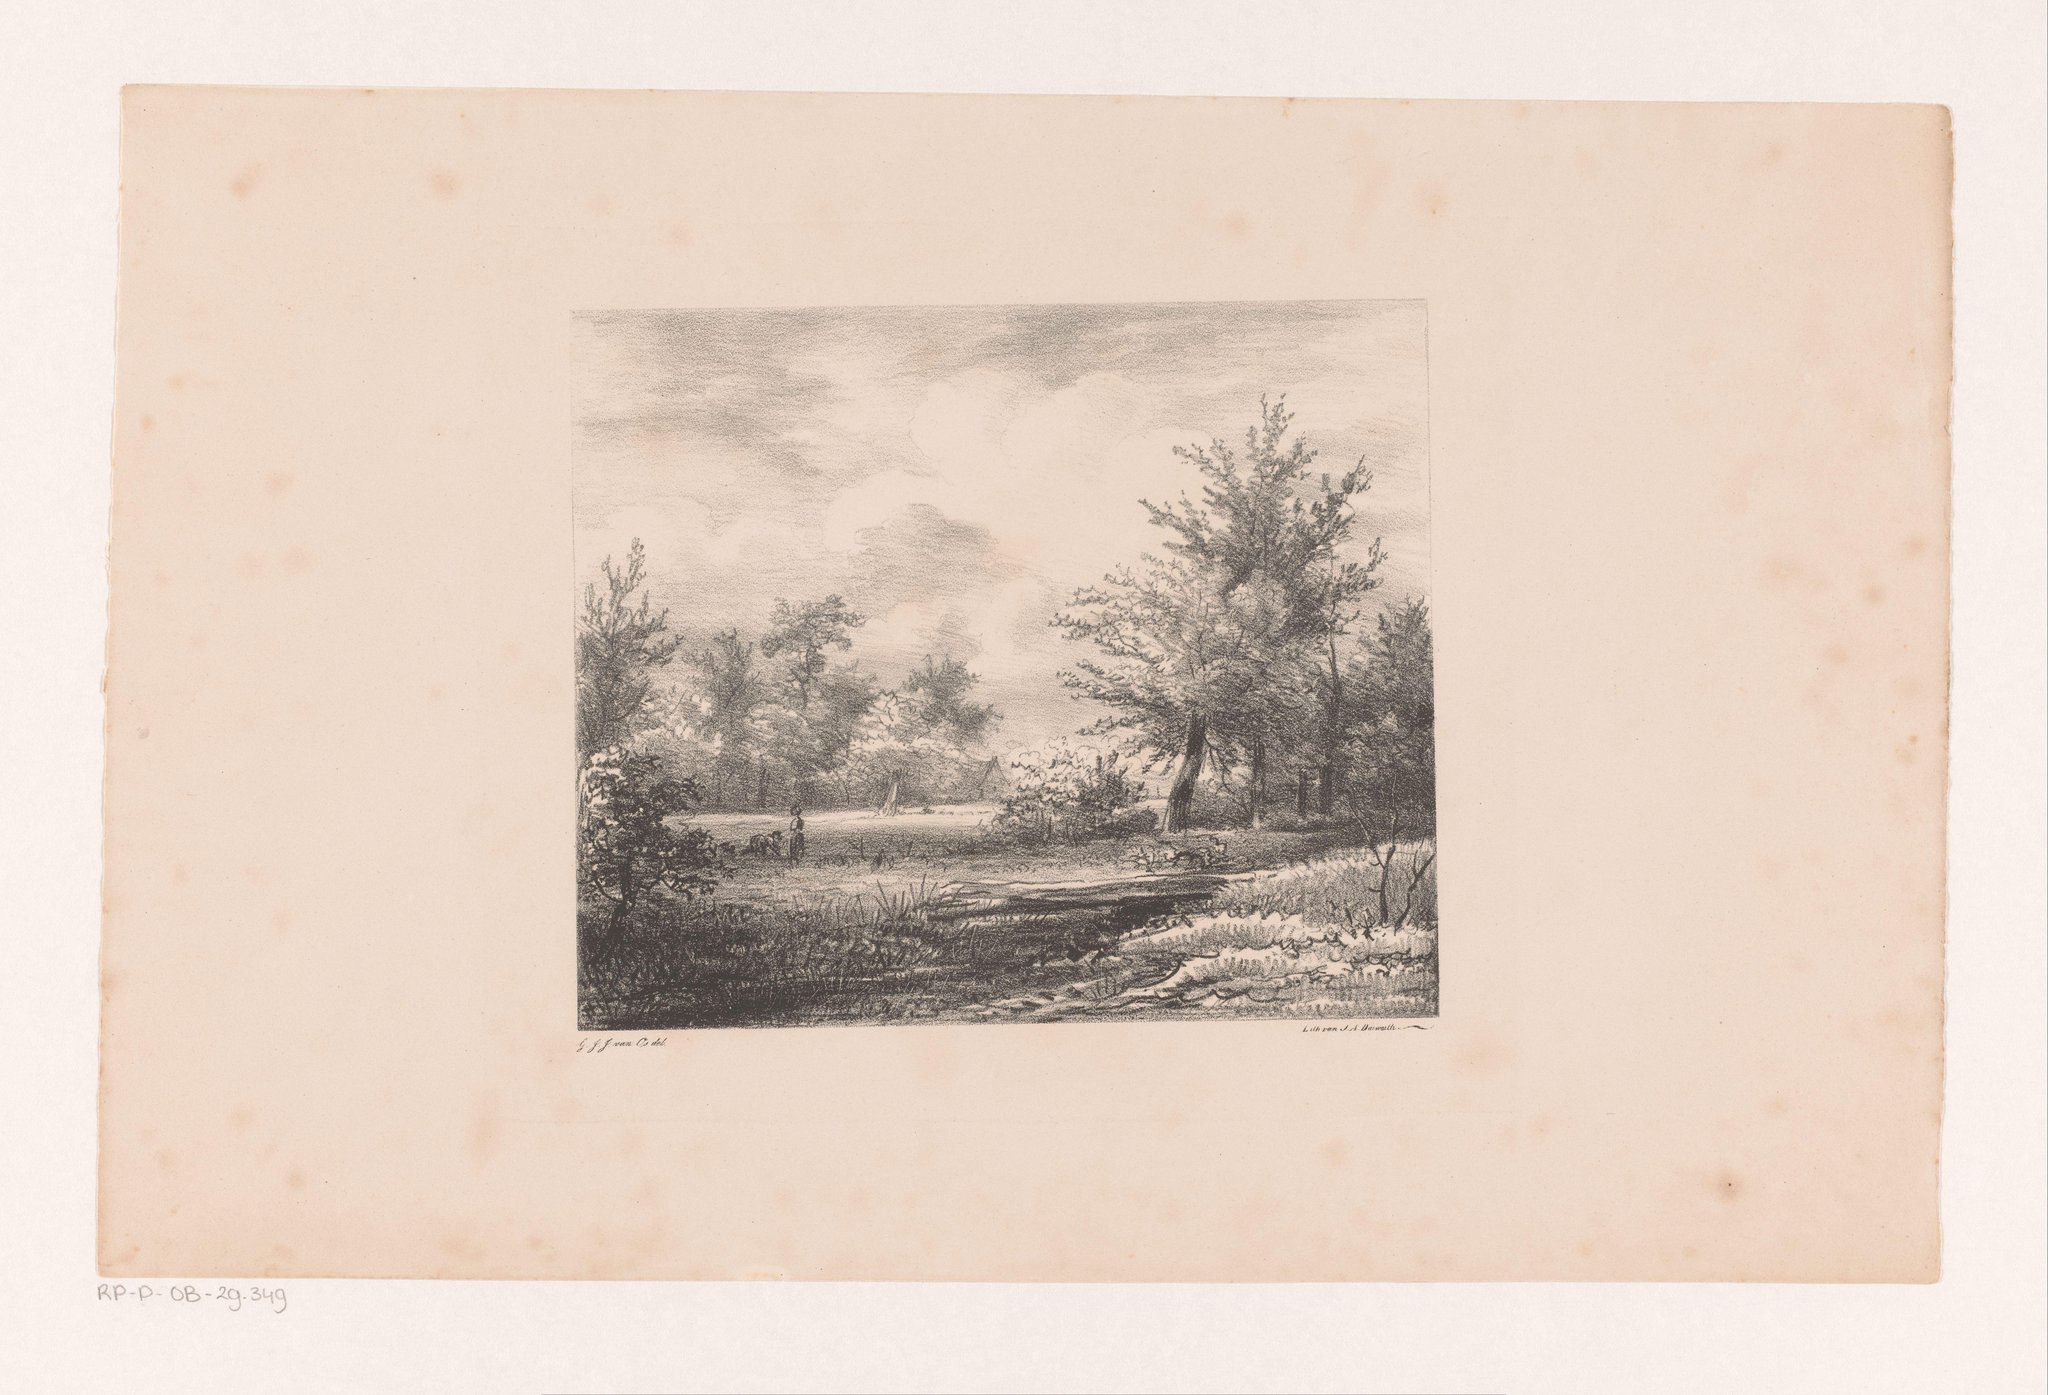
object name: print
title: Twee figuren in een landschap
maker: jean augustin daiwaille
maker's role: draughtsman, print maker, printer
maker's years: 1786-1850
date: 1820-1833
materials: paper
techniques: lithograph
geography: netherlands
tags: landscapes, farm or solitary house in landscape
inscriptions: collector's mark: Lugt 2228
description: Twee figuren in een landschap met bomen en in de achtergrond een boerderij.